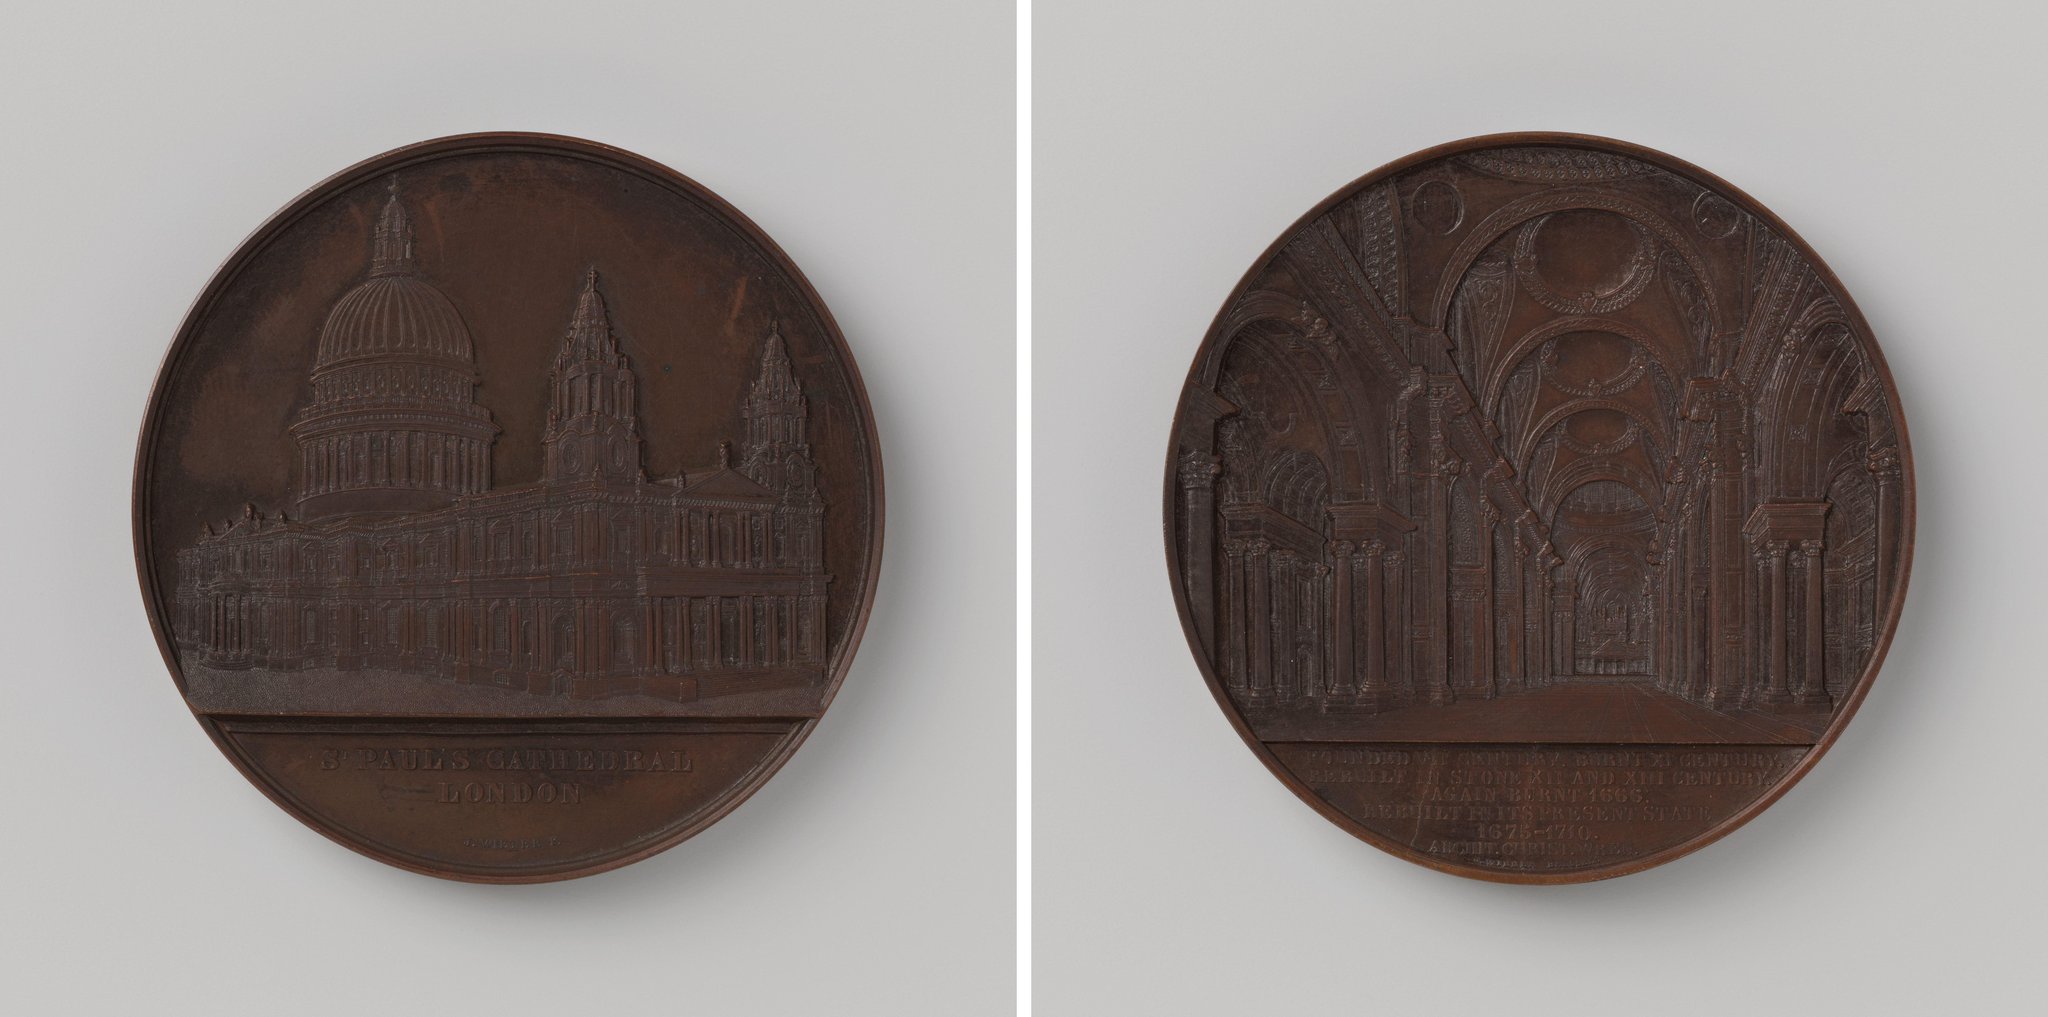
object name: history medal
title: St. Paul's Cathedral te Londen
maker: jacob wiener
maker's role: medailleur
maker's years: 1815-1899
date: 1849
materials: bronze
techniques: striking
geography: brussels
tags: saint paul's cathedral